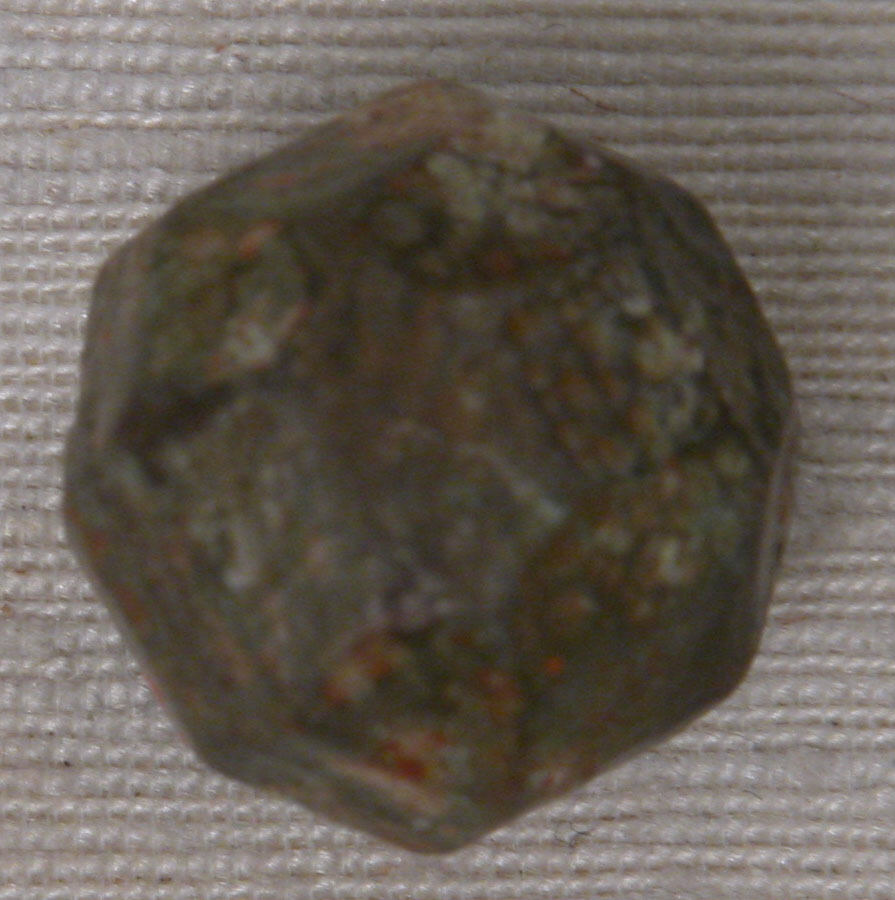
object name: weight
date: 801-1100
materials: bronze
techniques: casting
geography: iran